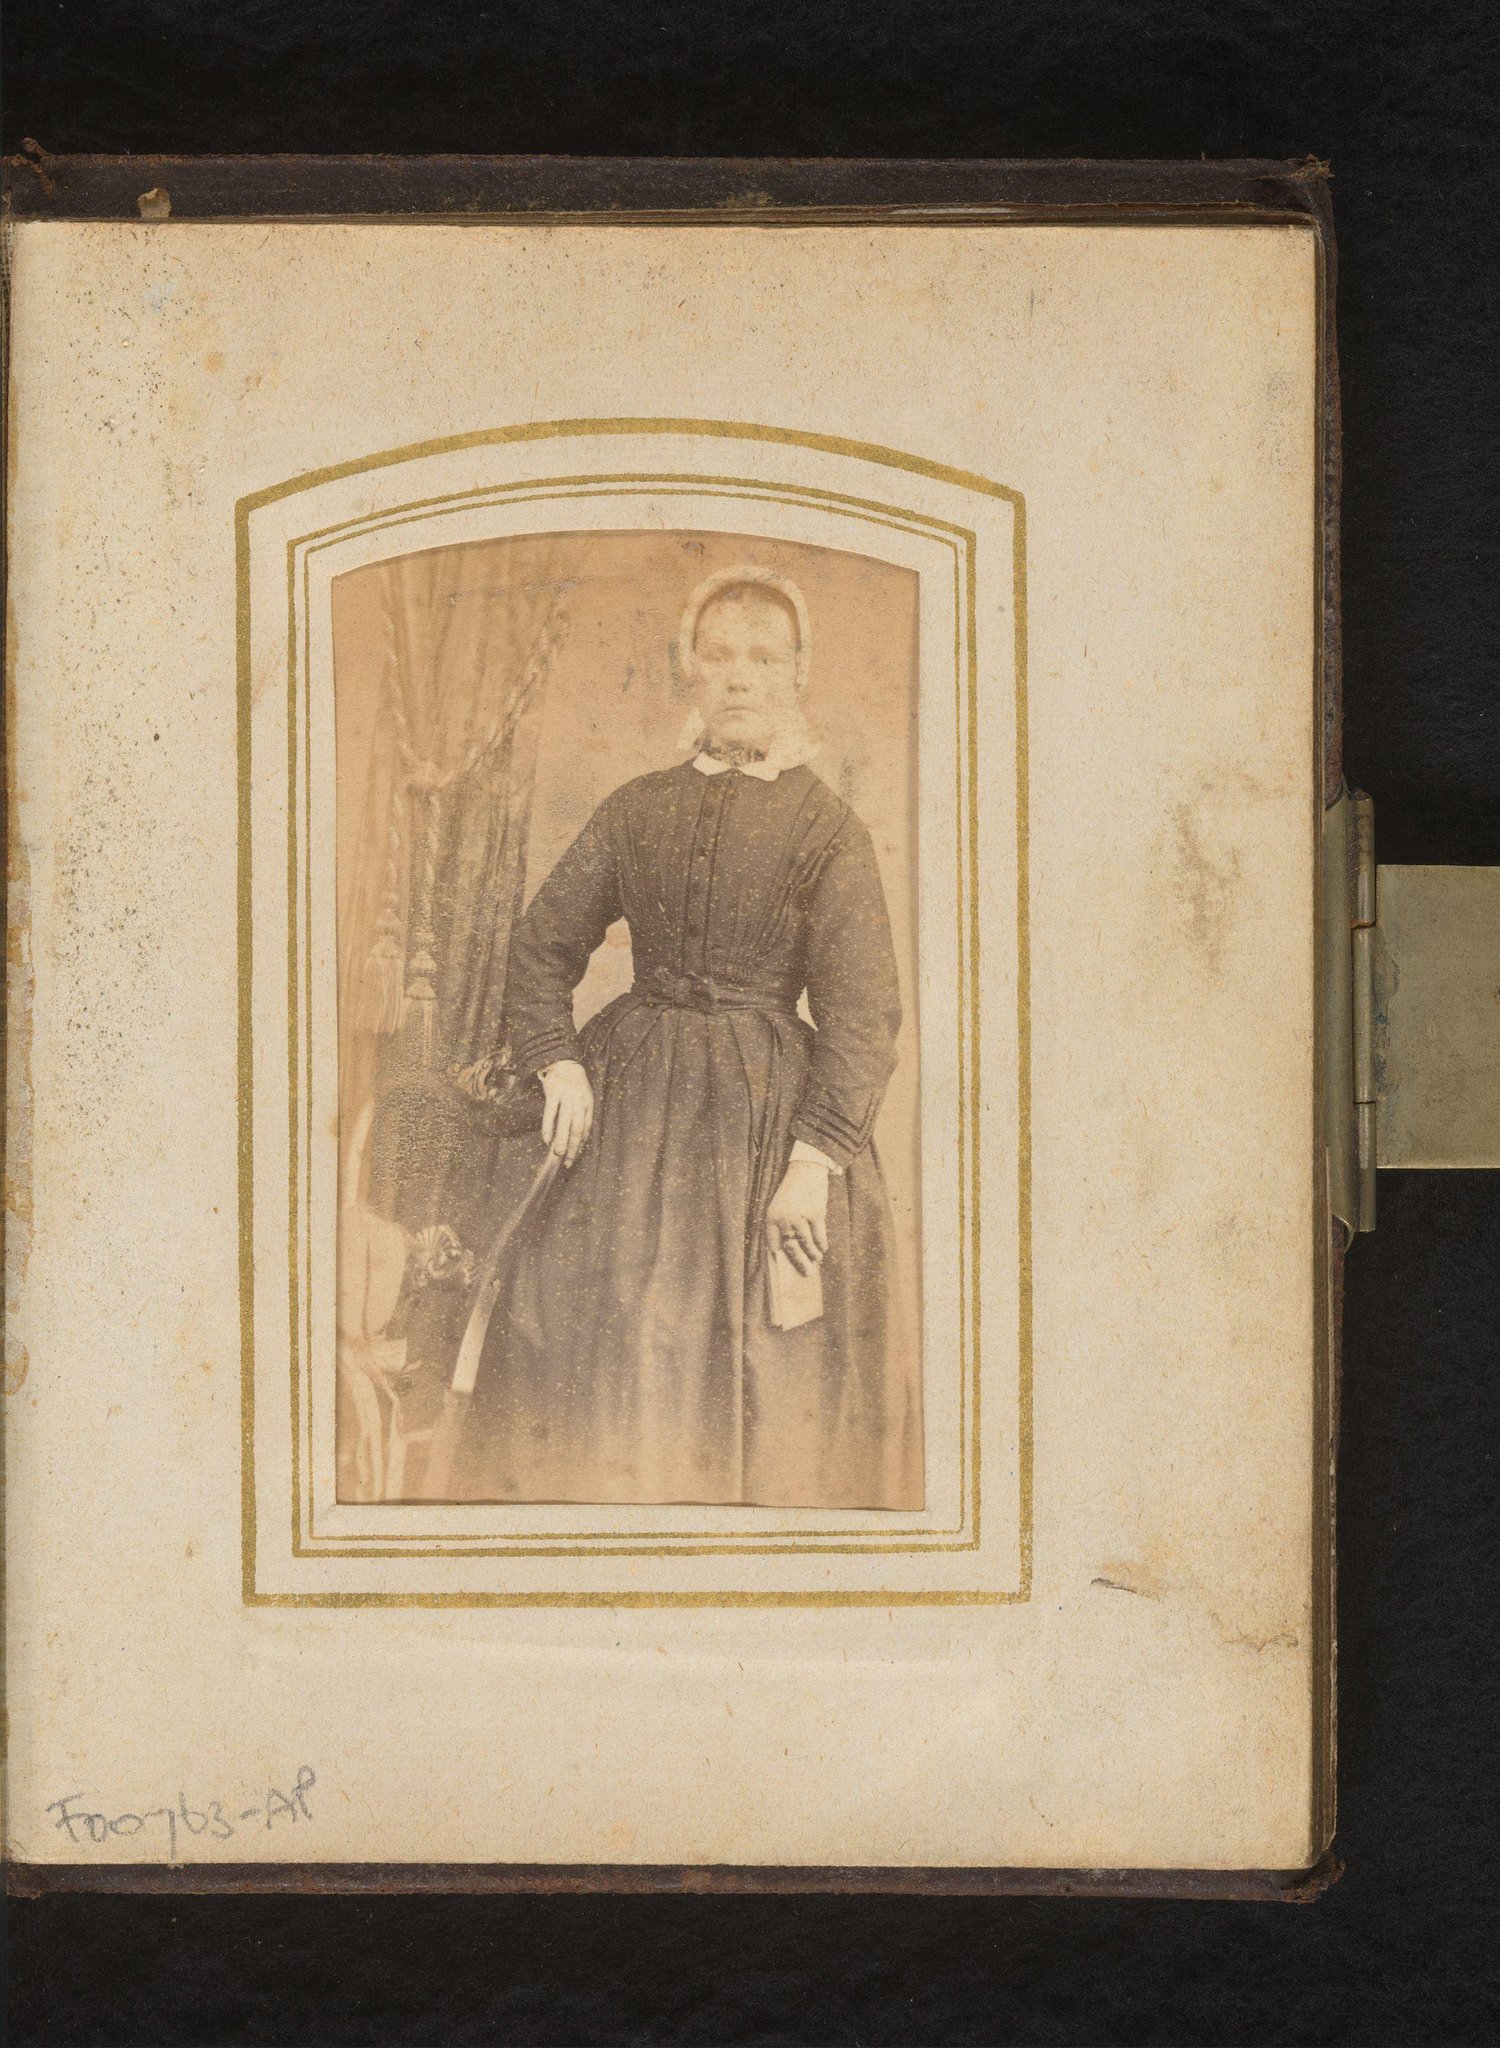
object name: photograph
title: Portret van een vrouw met muts volgens Overijsselse klederdracht met boek in de hand, staand bij een stoel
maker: Anonymous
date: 1860-1880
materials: cardboard, photographic support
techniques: albumen print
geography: netherlands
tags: historical persons - bb - woman, book, head-gear: cap, folk costume, regional costume, chair